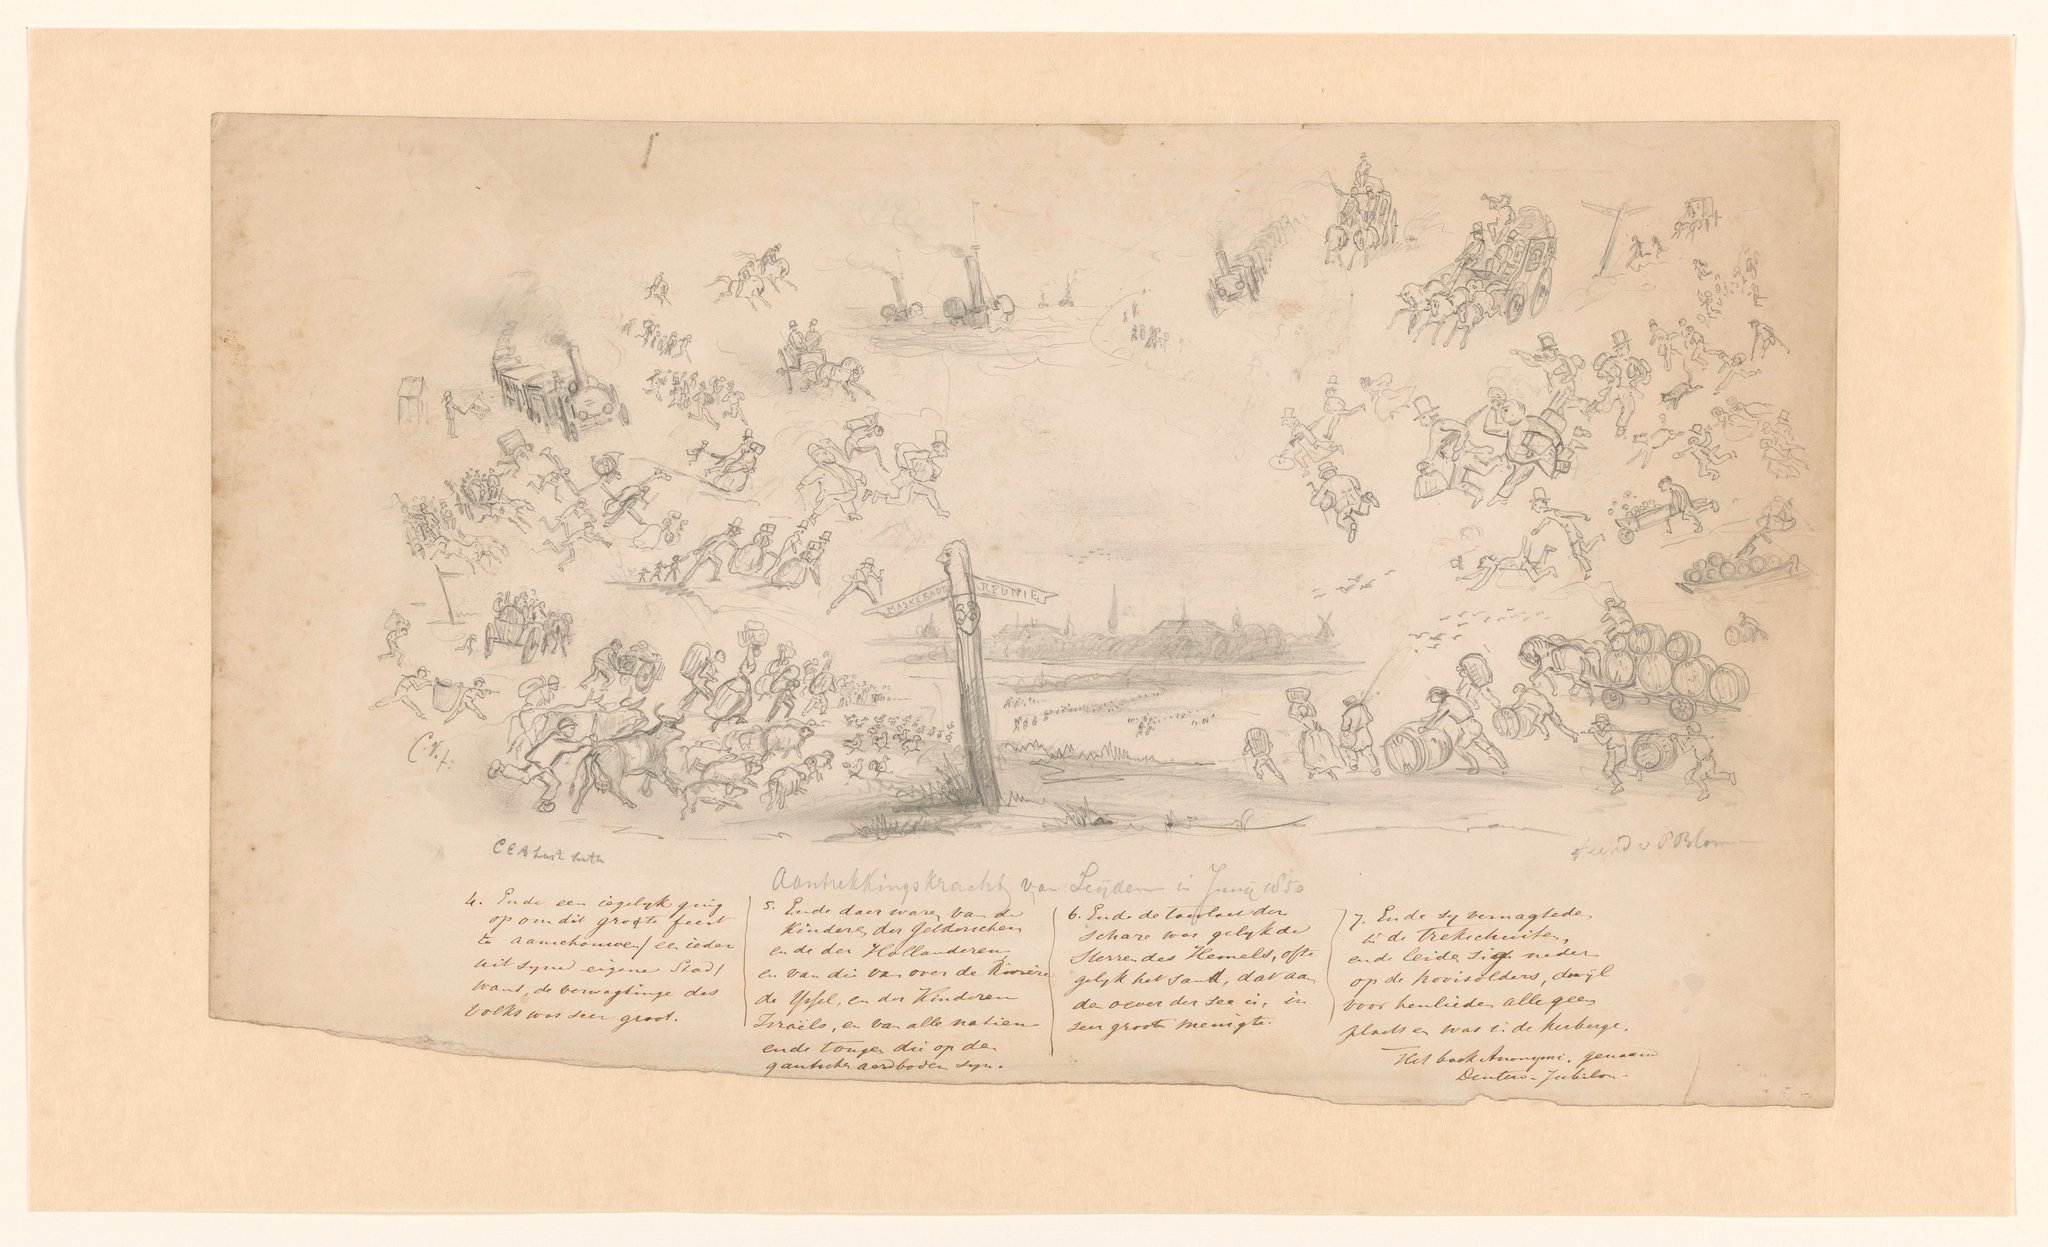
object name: design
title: Ontwerp voor Almanakprent: Aantrekkingskracht van Leyden in Junij 1850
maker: carel vosmaer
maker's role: draughtsman, print maker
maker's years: 1826-1888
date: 1836-1888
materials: ink, paper, pencil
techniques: pen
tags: names of organizations, companies, trade unions, etc., university, historical events and situations, leiden